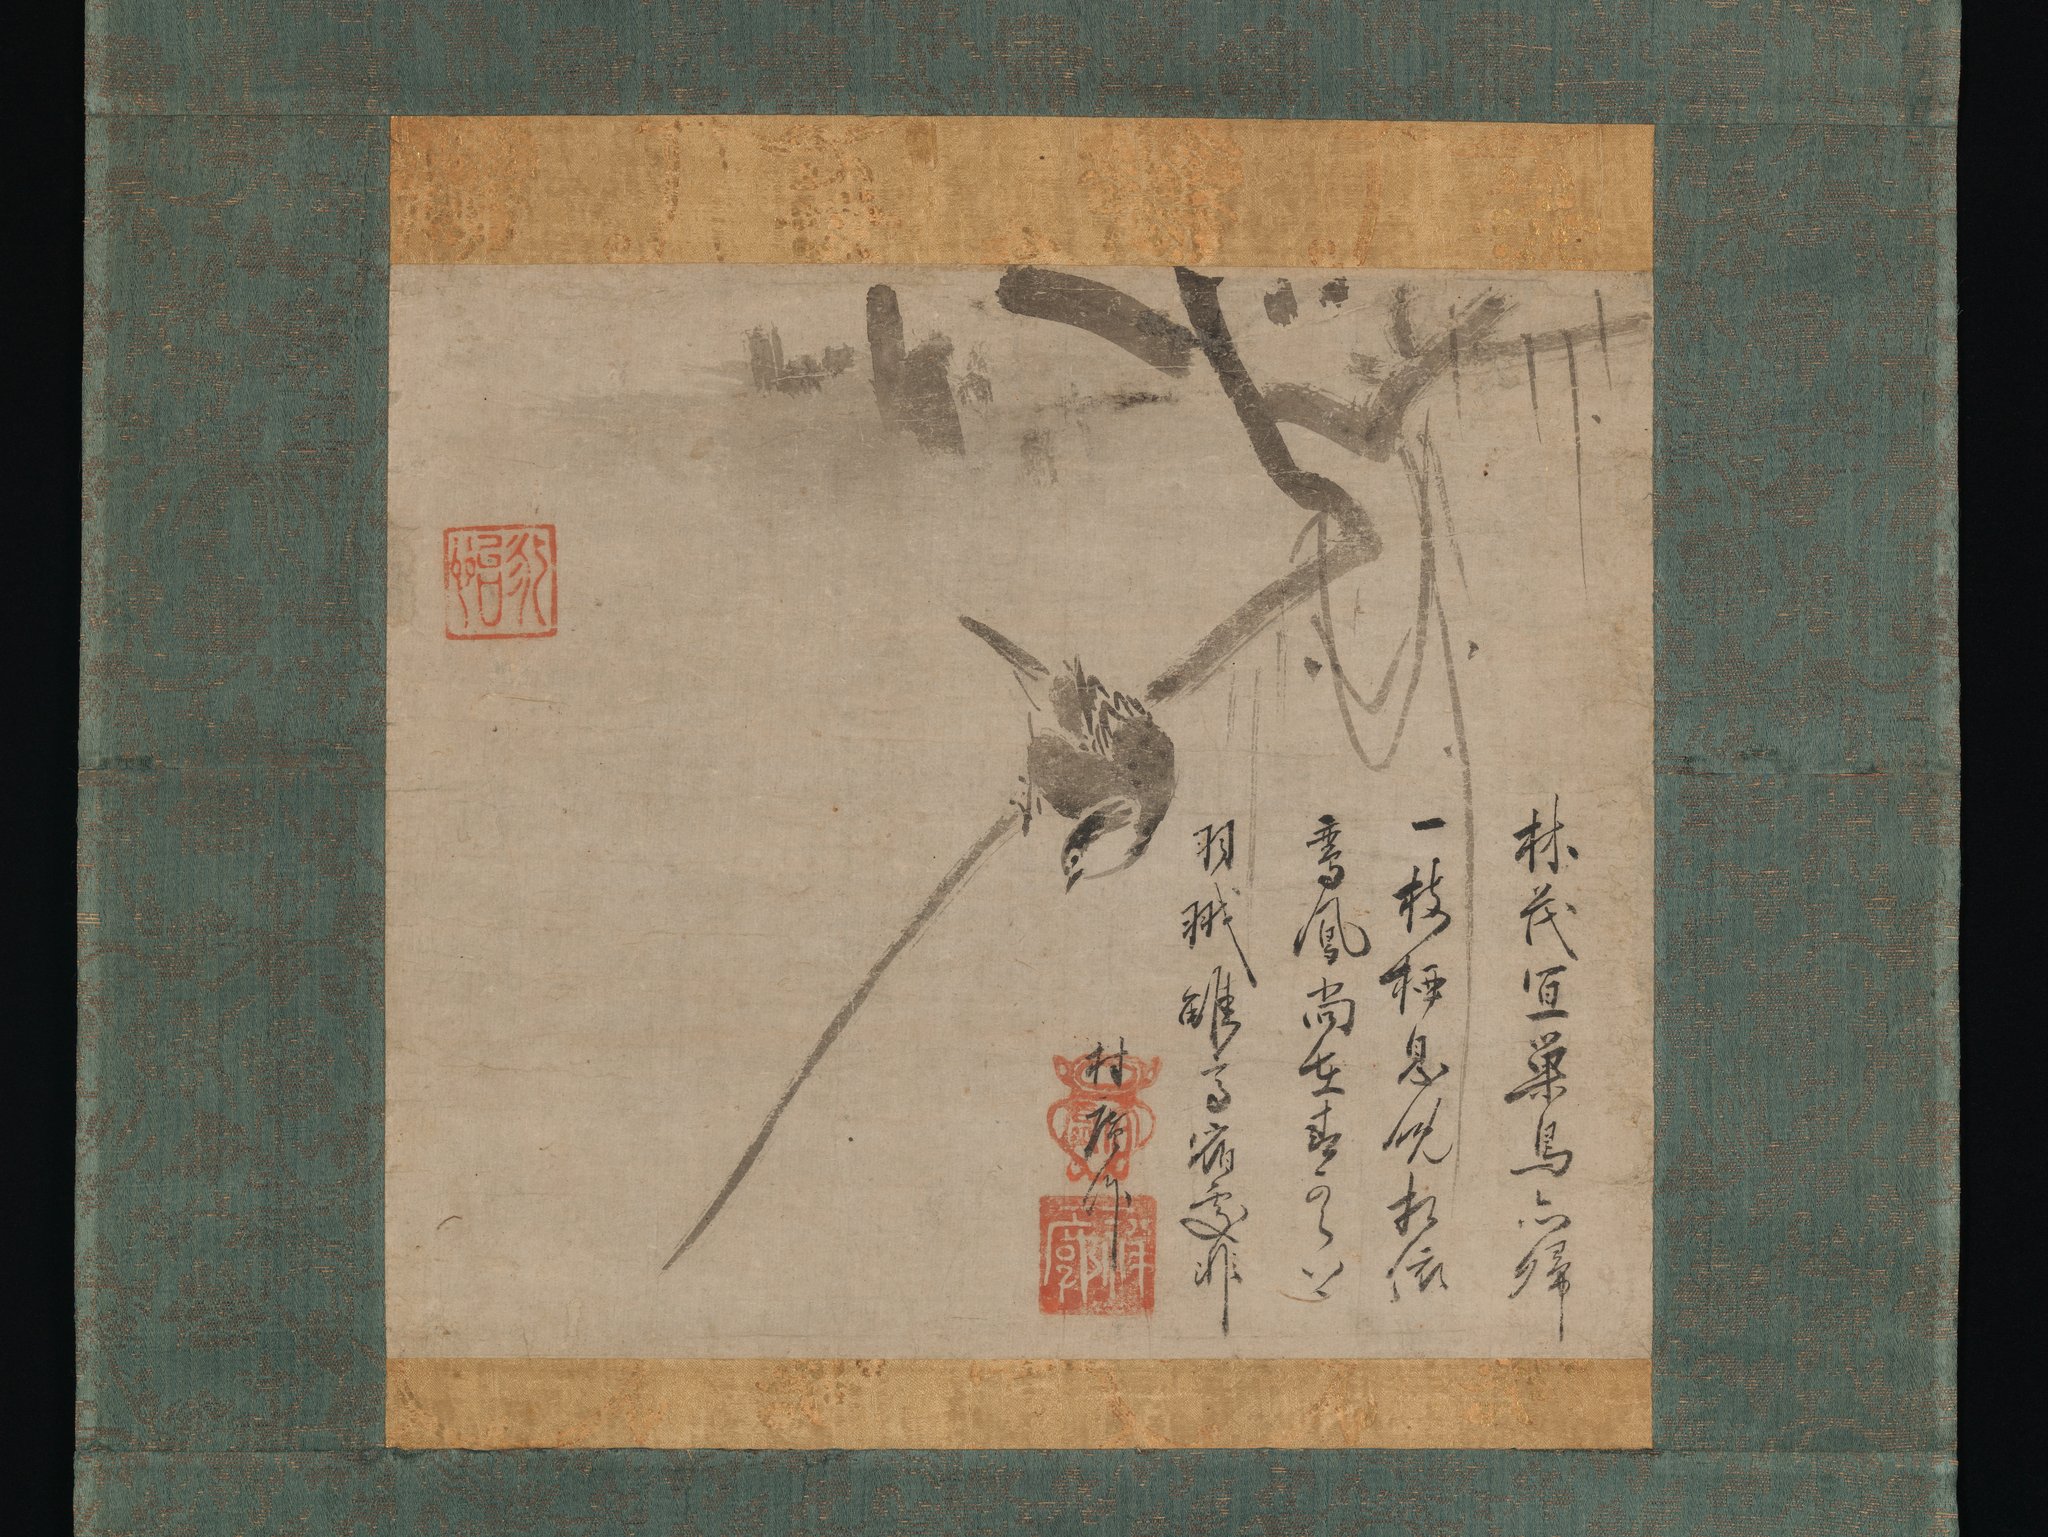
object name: hanging scroll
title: Bird on a Branch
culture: japanese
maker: unkei eii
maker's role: artist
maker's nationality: japanese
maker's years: 1500-1549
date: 1535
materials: ink, paper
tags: birds